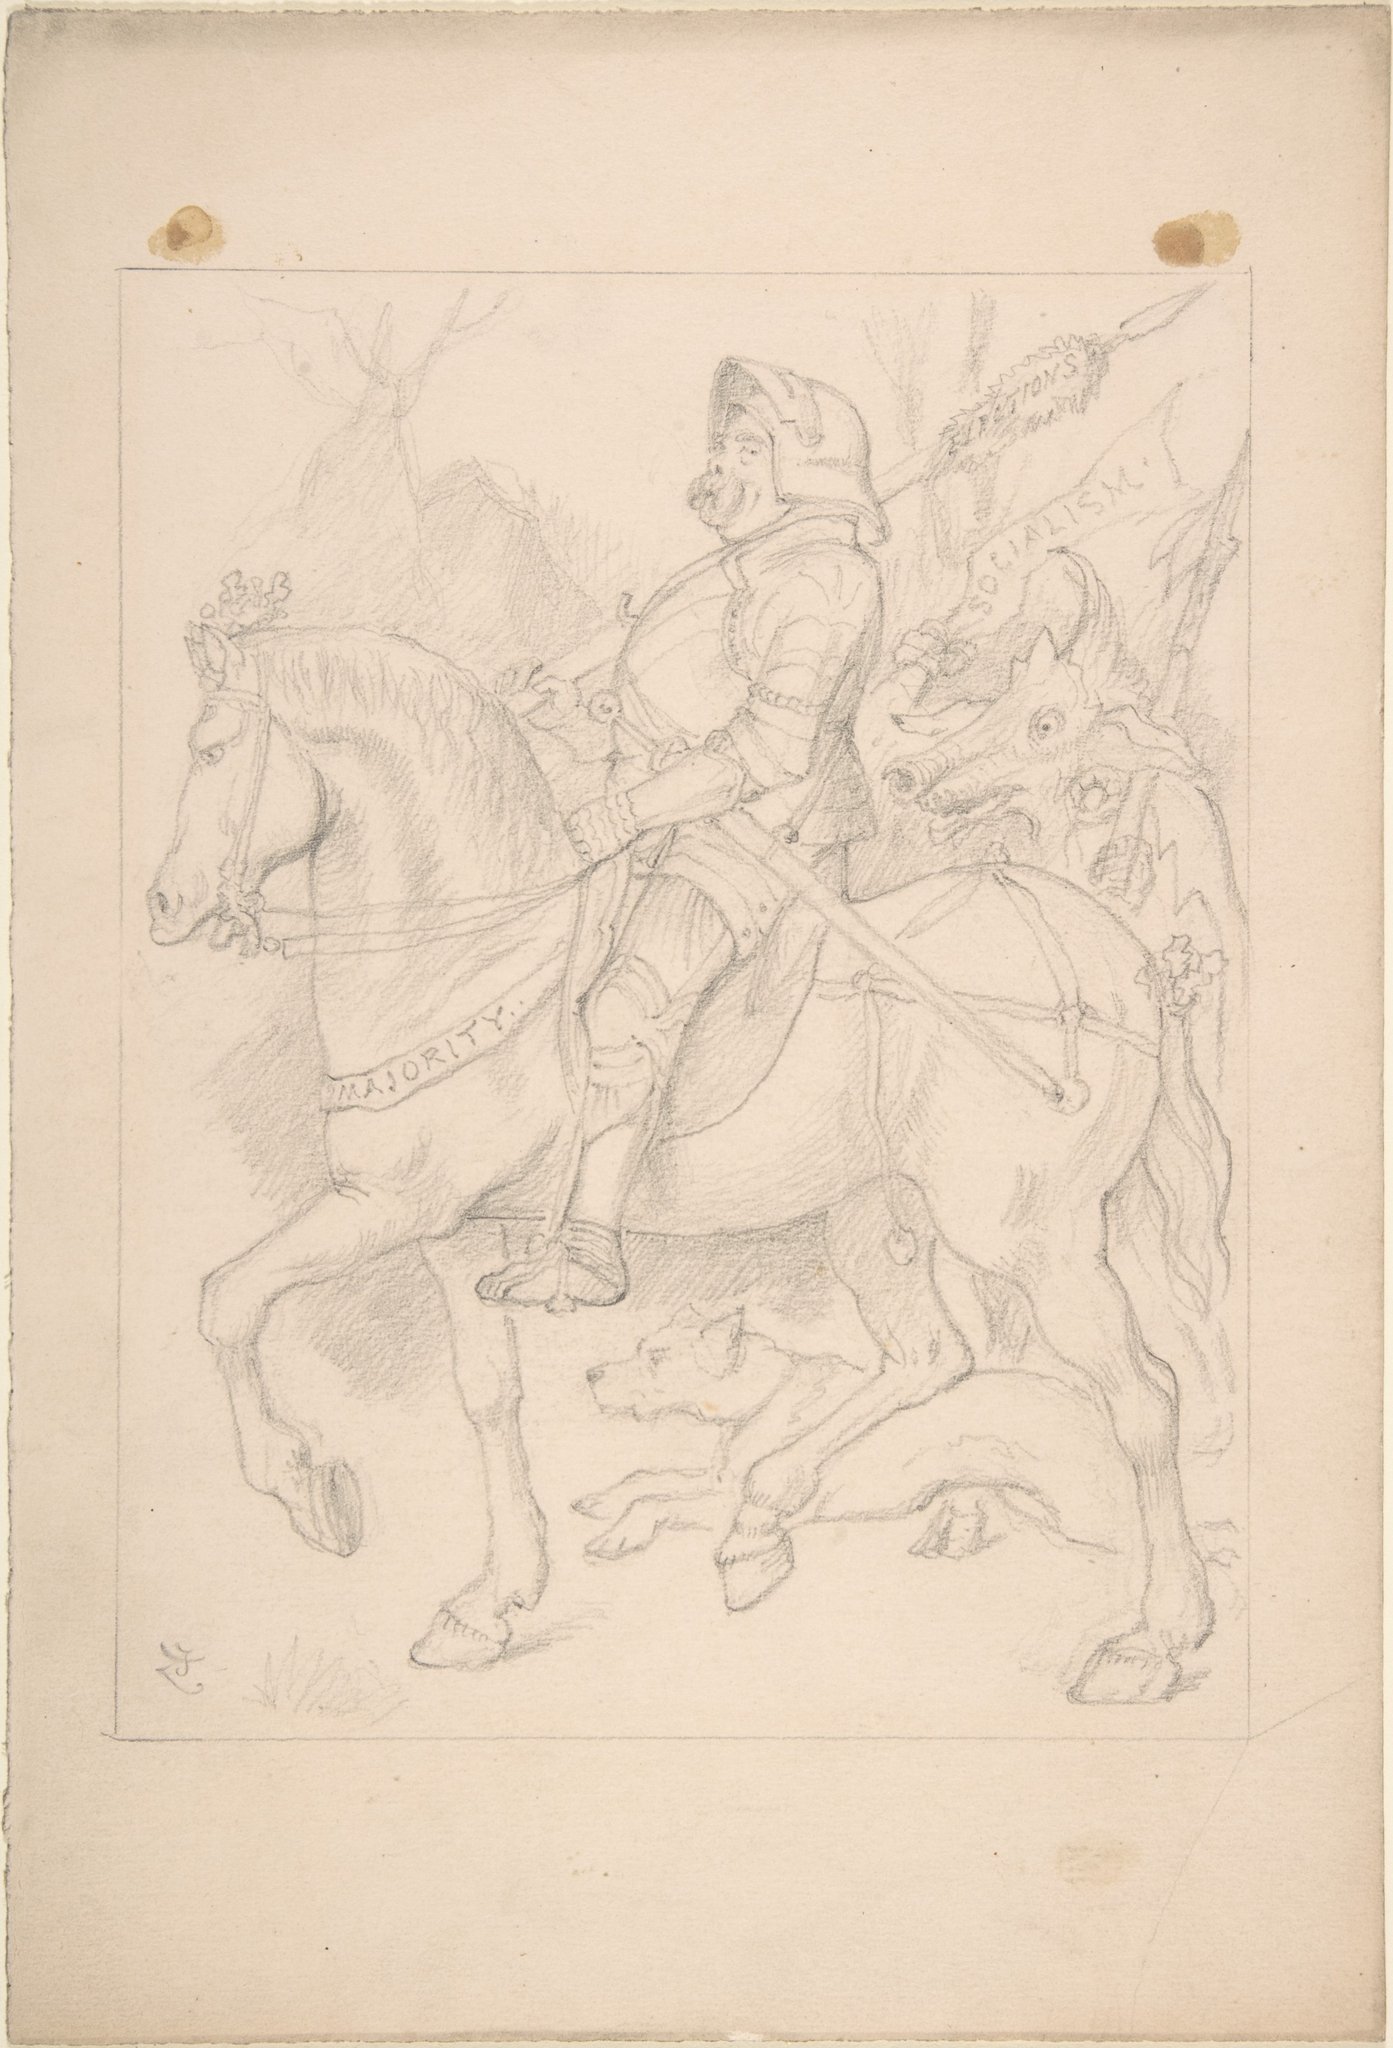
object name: drawing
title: The Knight and His Companion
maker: sir john tenniel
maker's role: artist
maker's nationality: british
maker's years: 1820-1914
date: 1887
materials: graphite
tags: men,dogs,horses